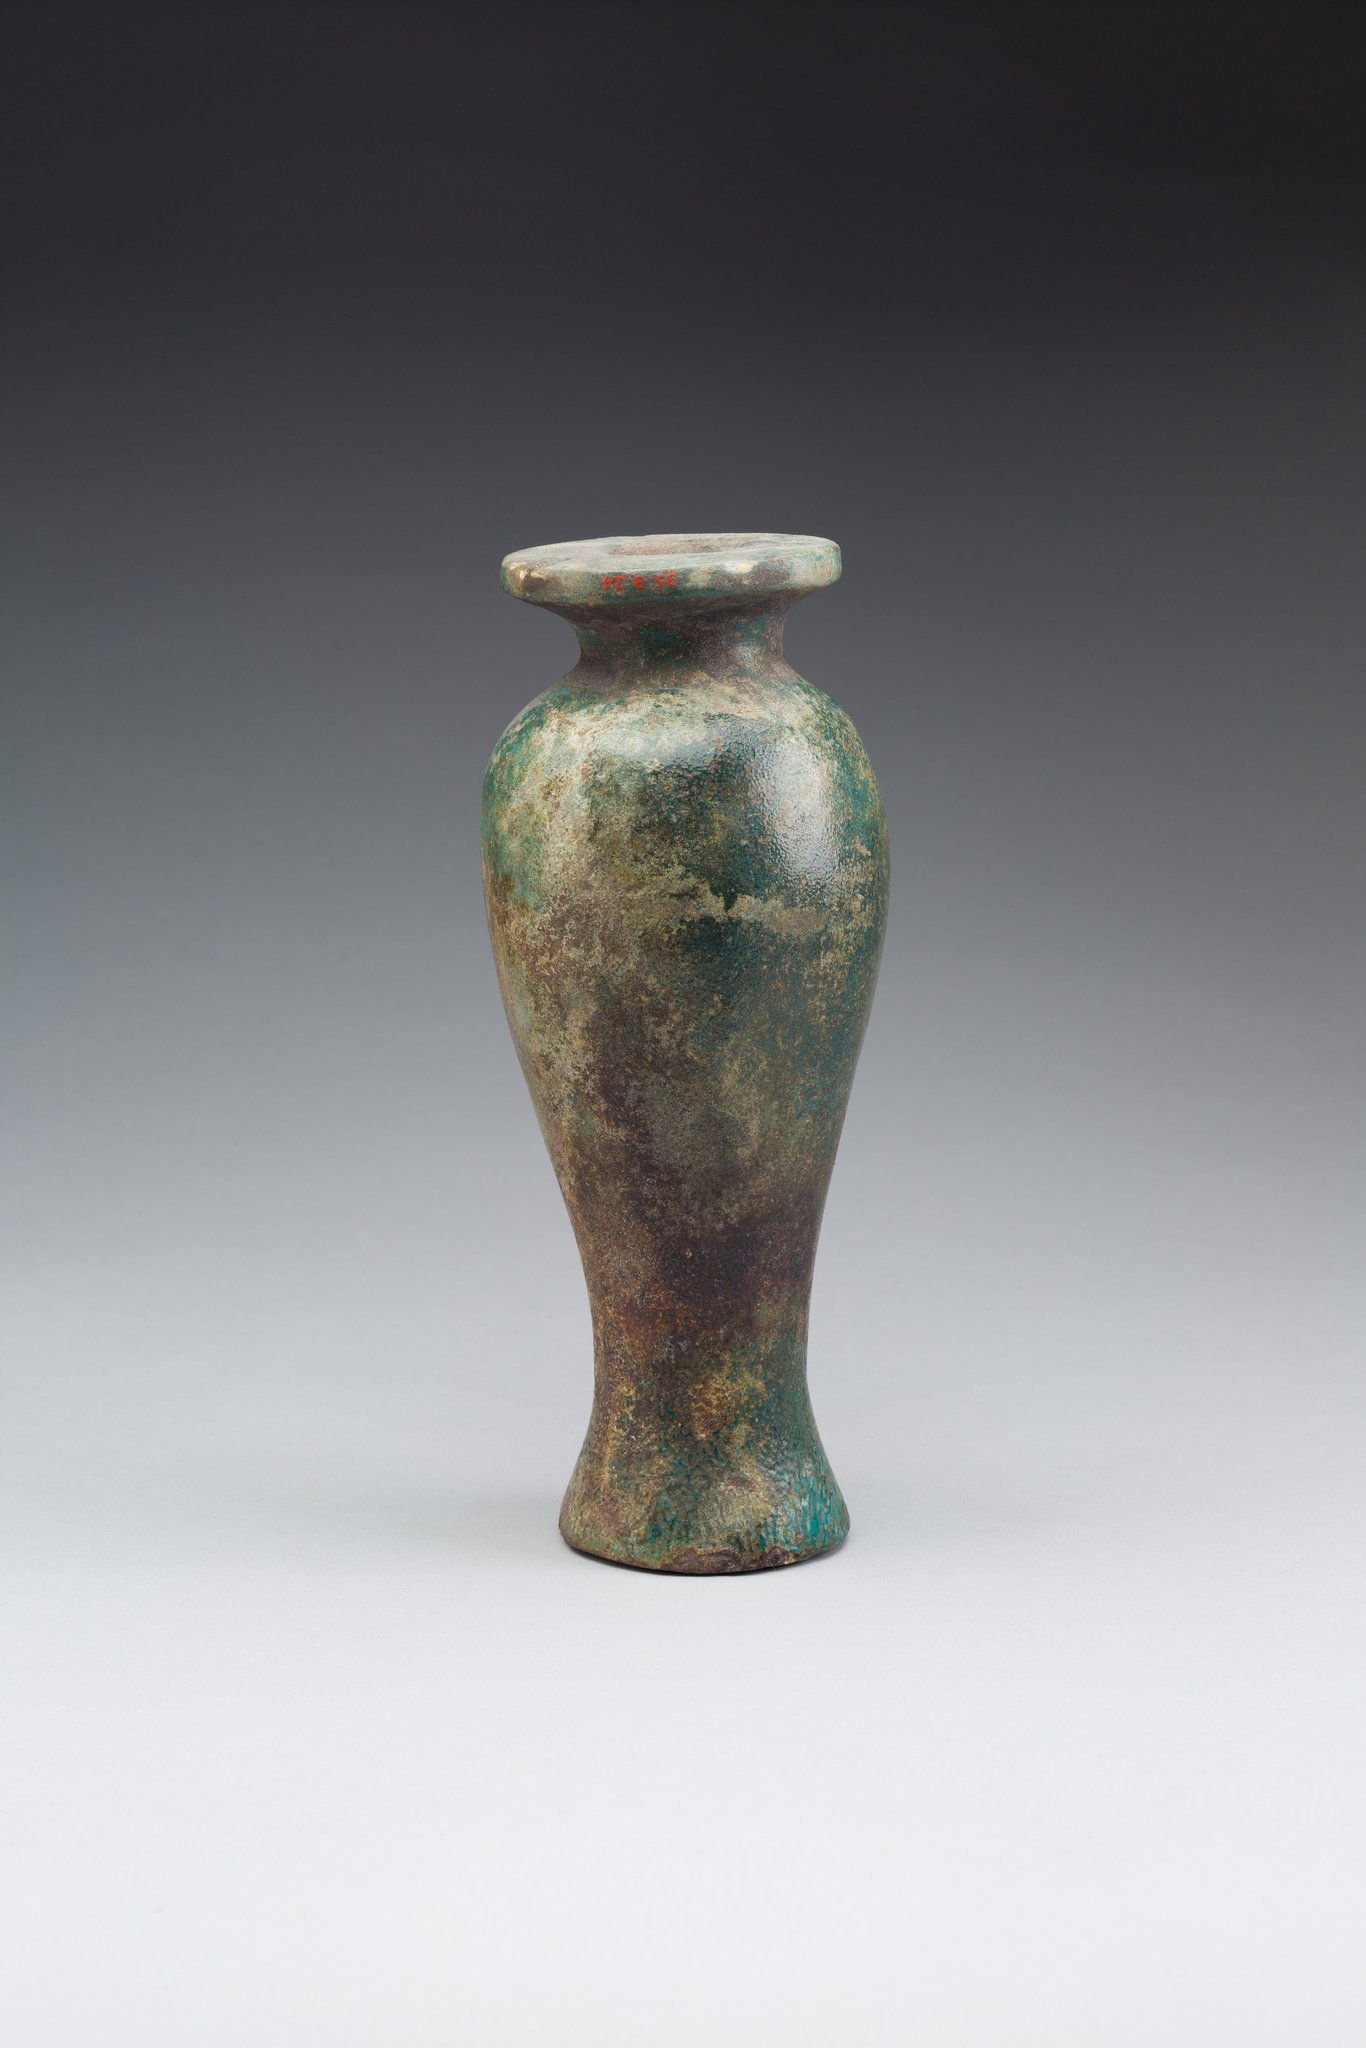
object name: libation, he, amenemhat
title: Hes Vase from the Burial of Amenemhat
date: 1504-1447 BCE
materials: faience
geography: egypt